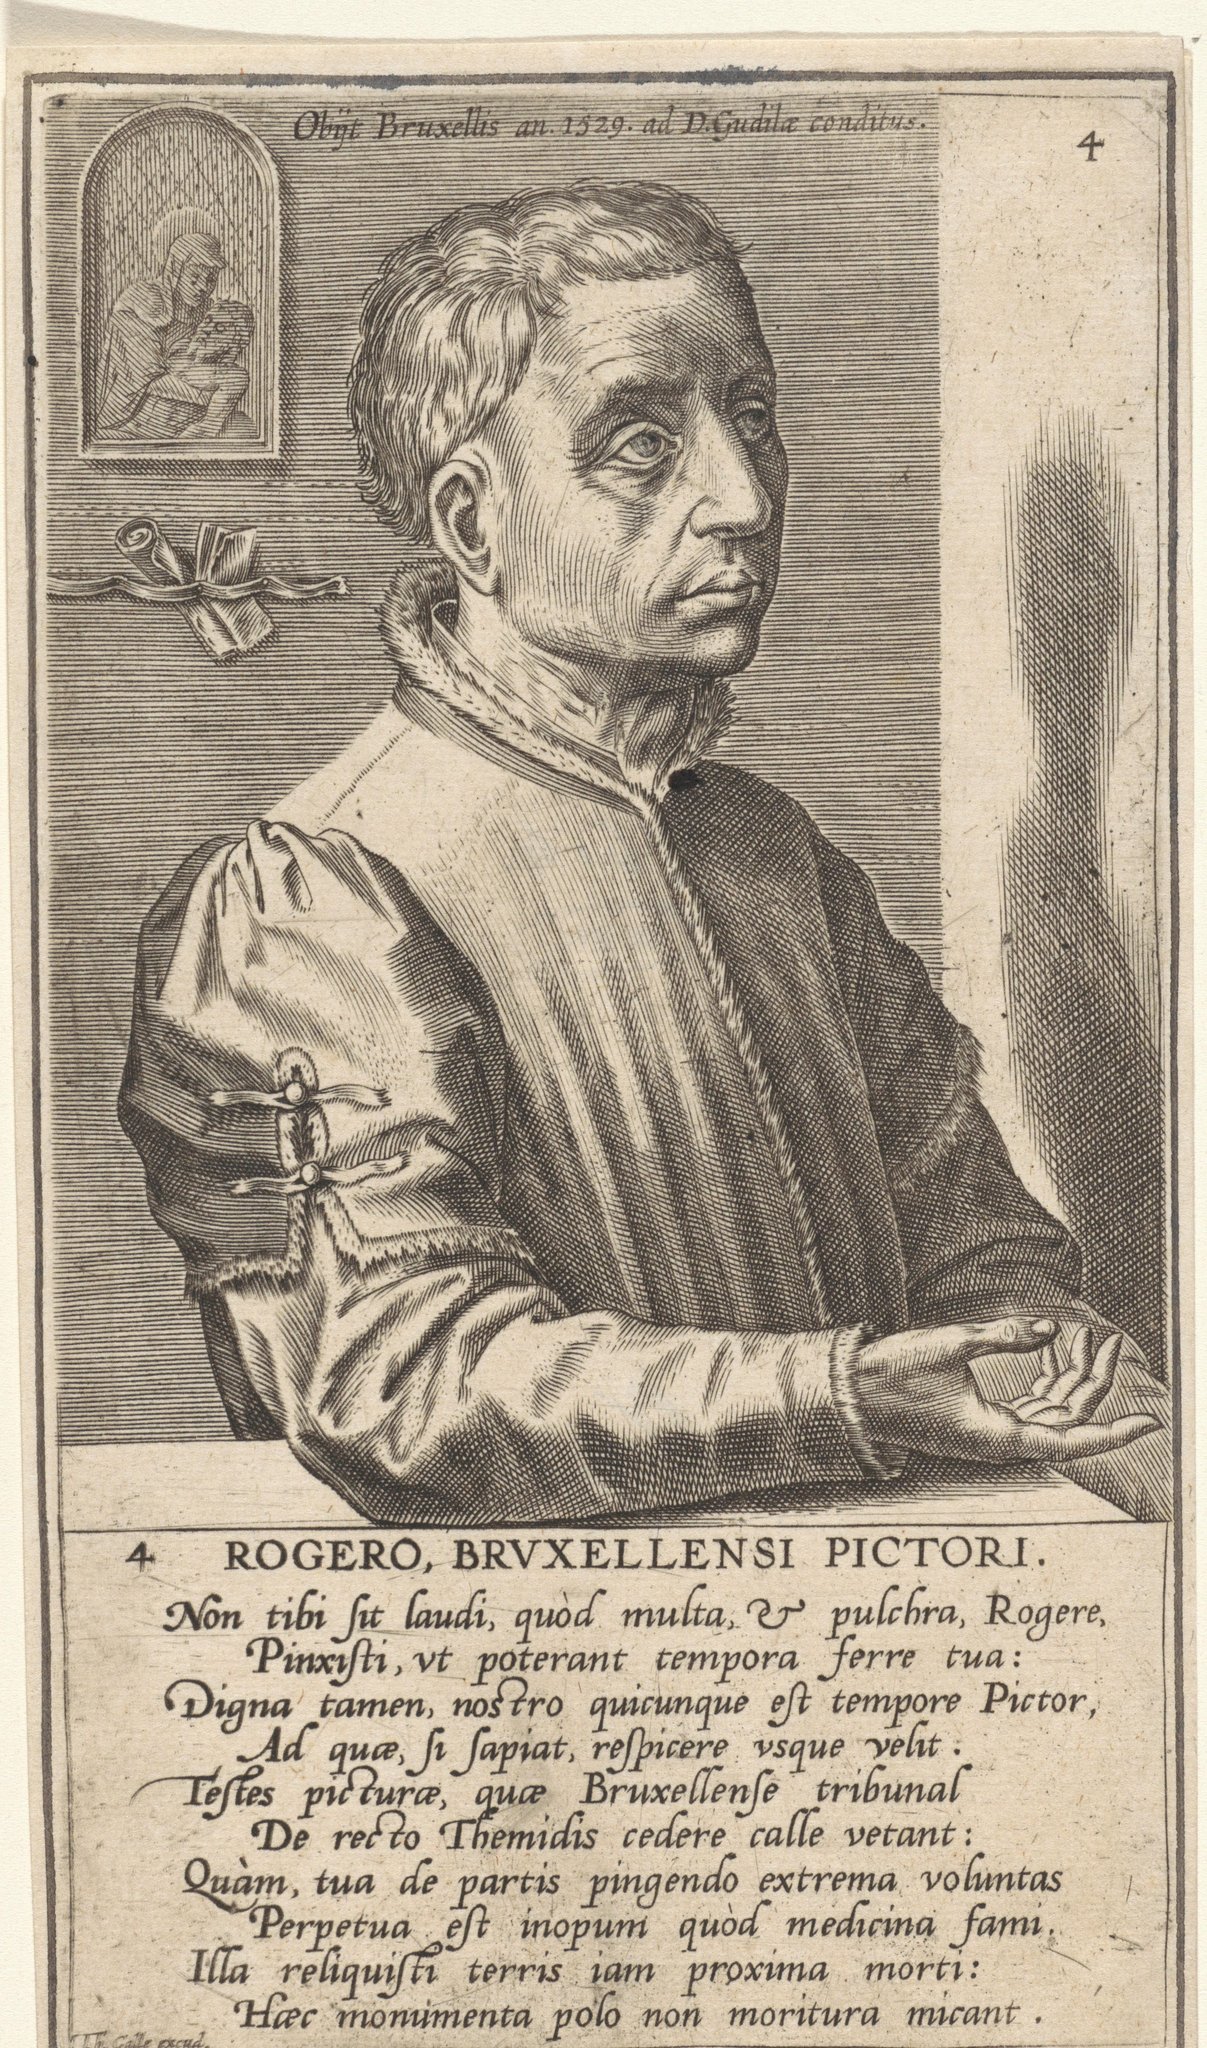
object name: print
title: Portret van de schilder Rogier van der Weyden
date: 1600-1650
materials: paper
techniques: engraving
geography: antwerp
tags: brussels, painter, rogier van der weyden, portrait, self-portrait of painter, the dead christ in mary's lap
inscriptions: collector's mark: Lugt 2228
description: Aan de muur achter hem een schilderij van de piëta. Boven de geportretteerde een regel met biografische gegevens in het Latijn. In de marge een tienregelig onderschrift in het Latijn.